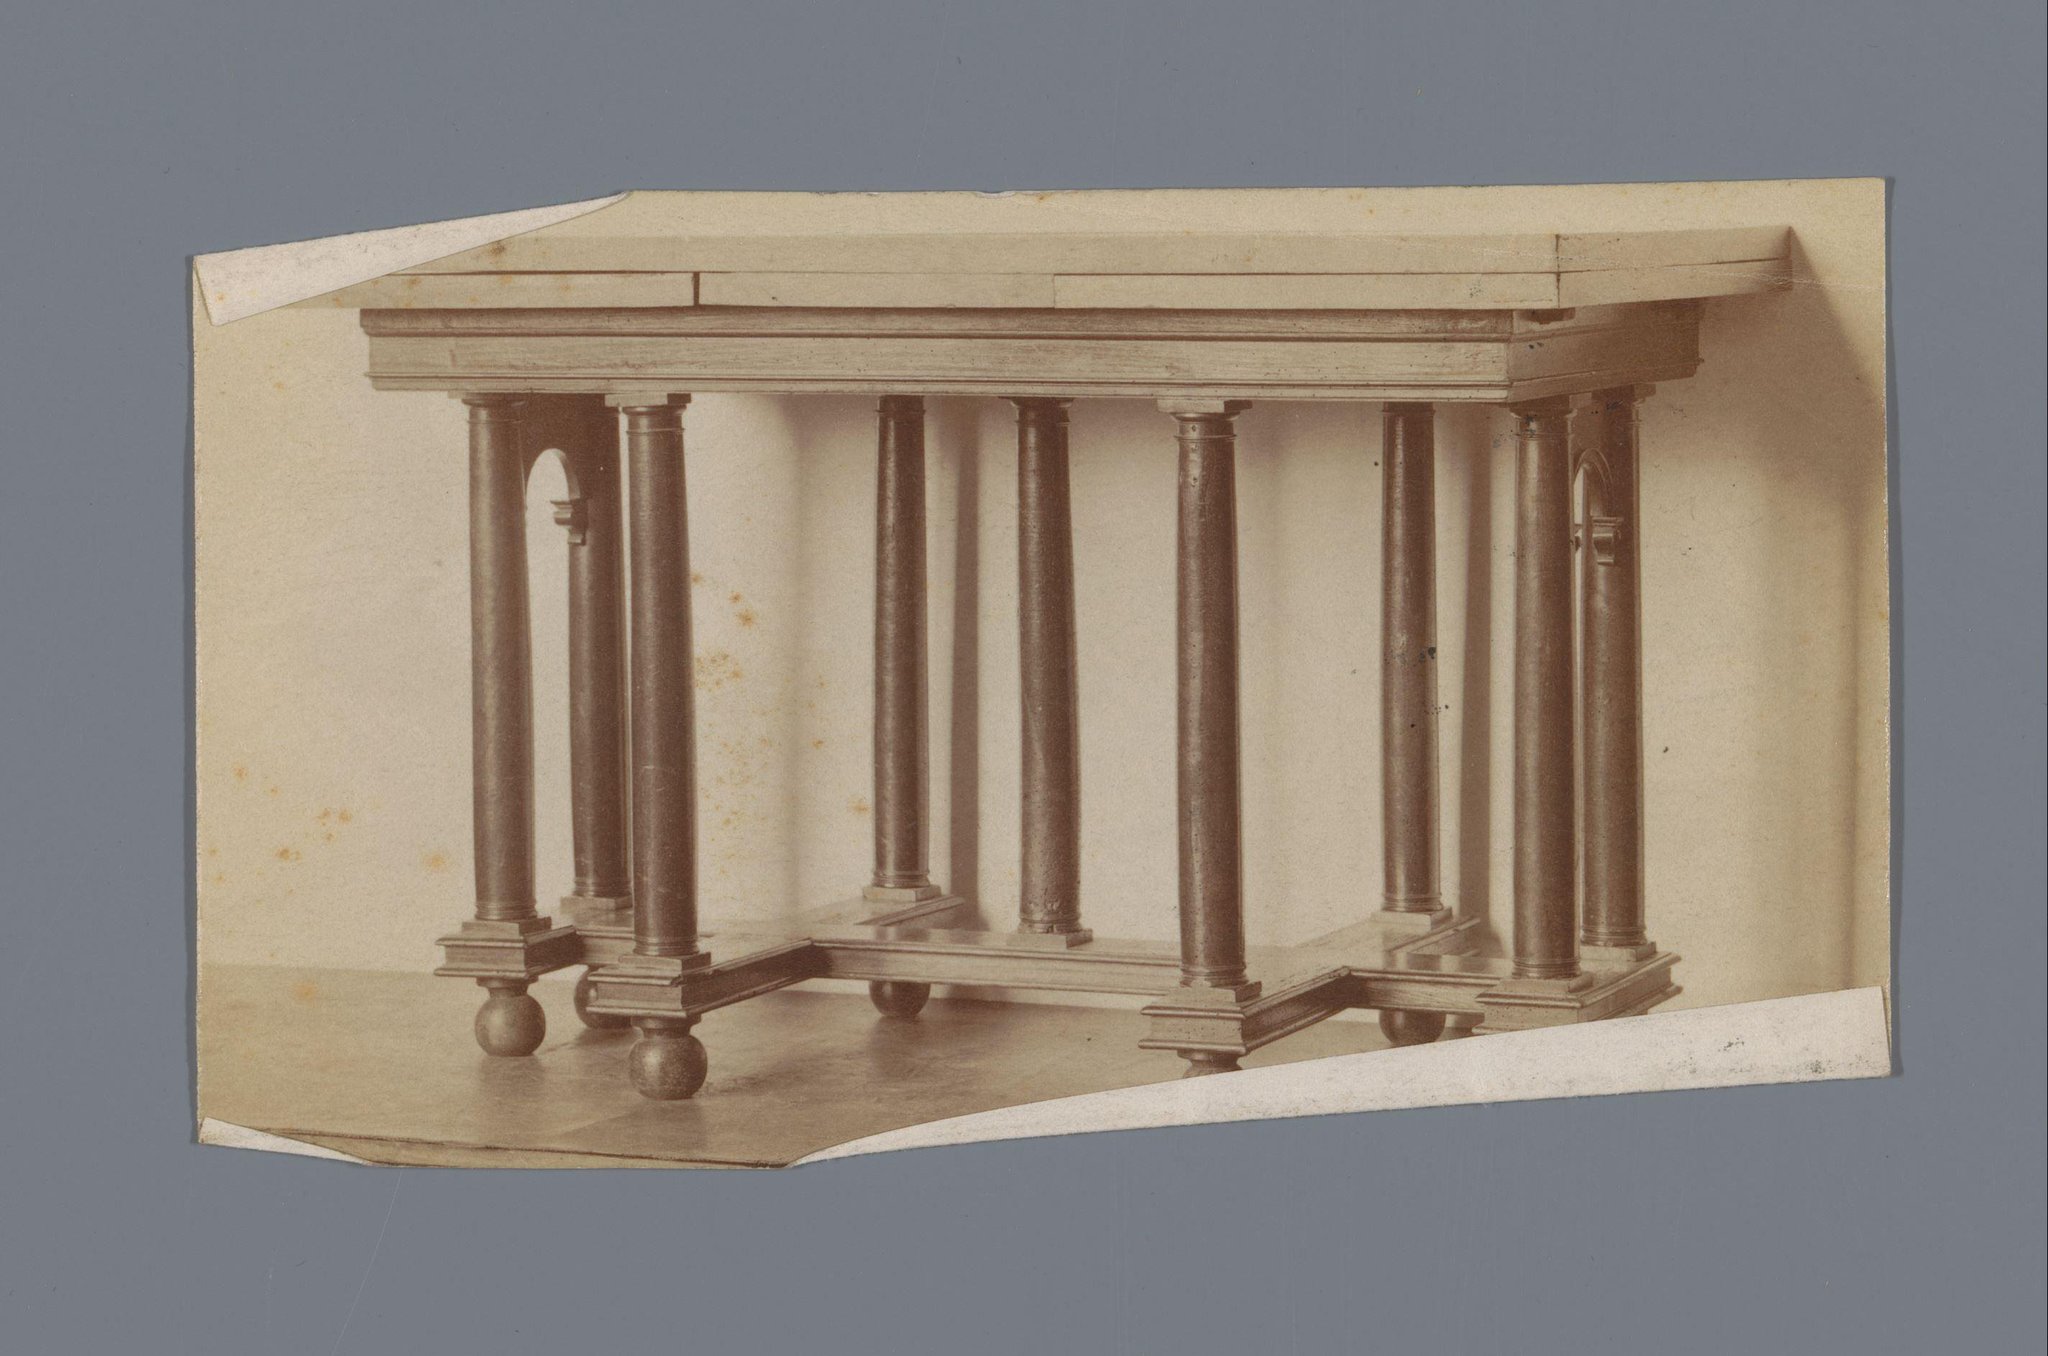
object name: photograph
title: Tafel met gestileerde zuilen als poten die rusten op bollen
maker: Anonymous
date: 1875-1900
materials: photographic support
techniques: albumen print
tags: table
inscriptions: number: ‘Vervalt’, collector's mark: ‘Instituut voor kunst-nijverheidsonderwijs Gabriël Metsustraat No. 16, Amsterdam’